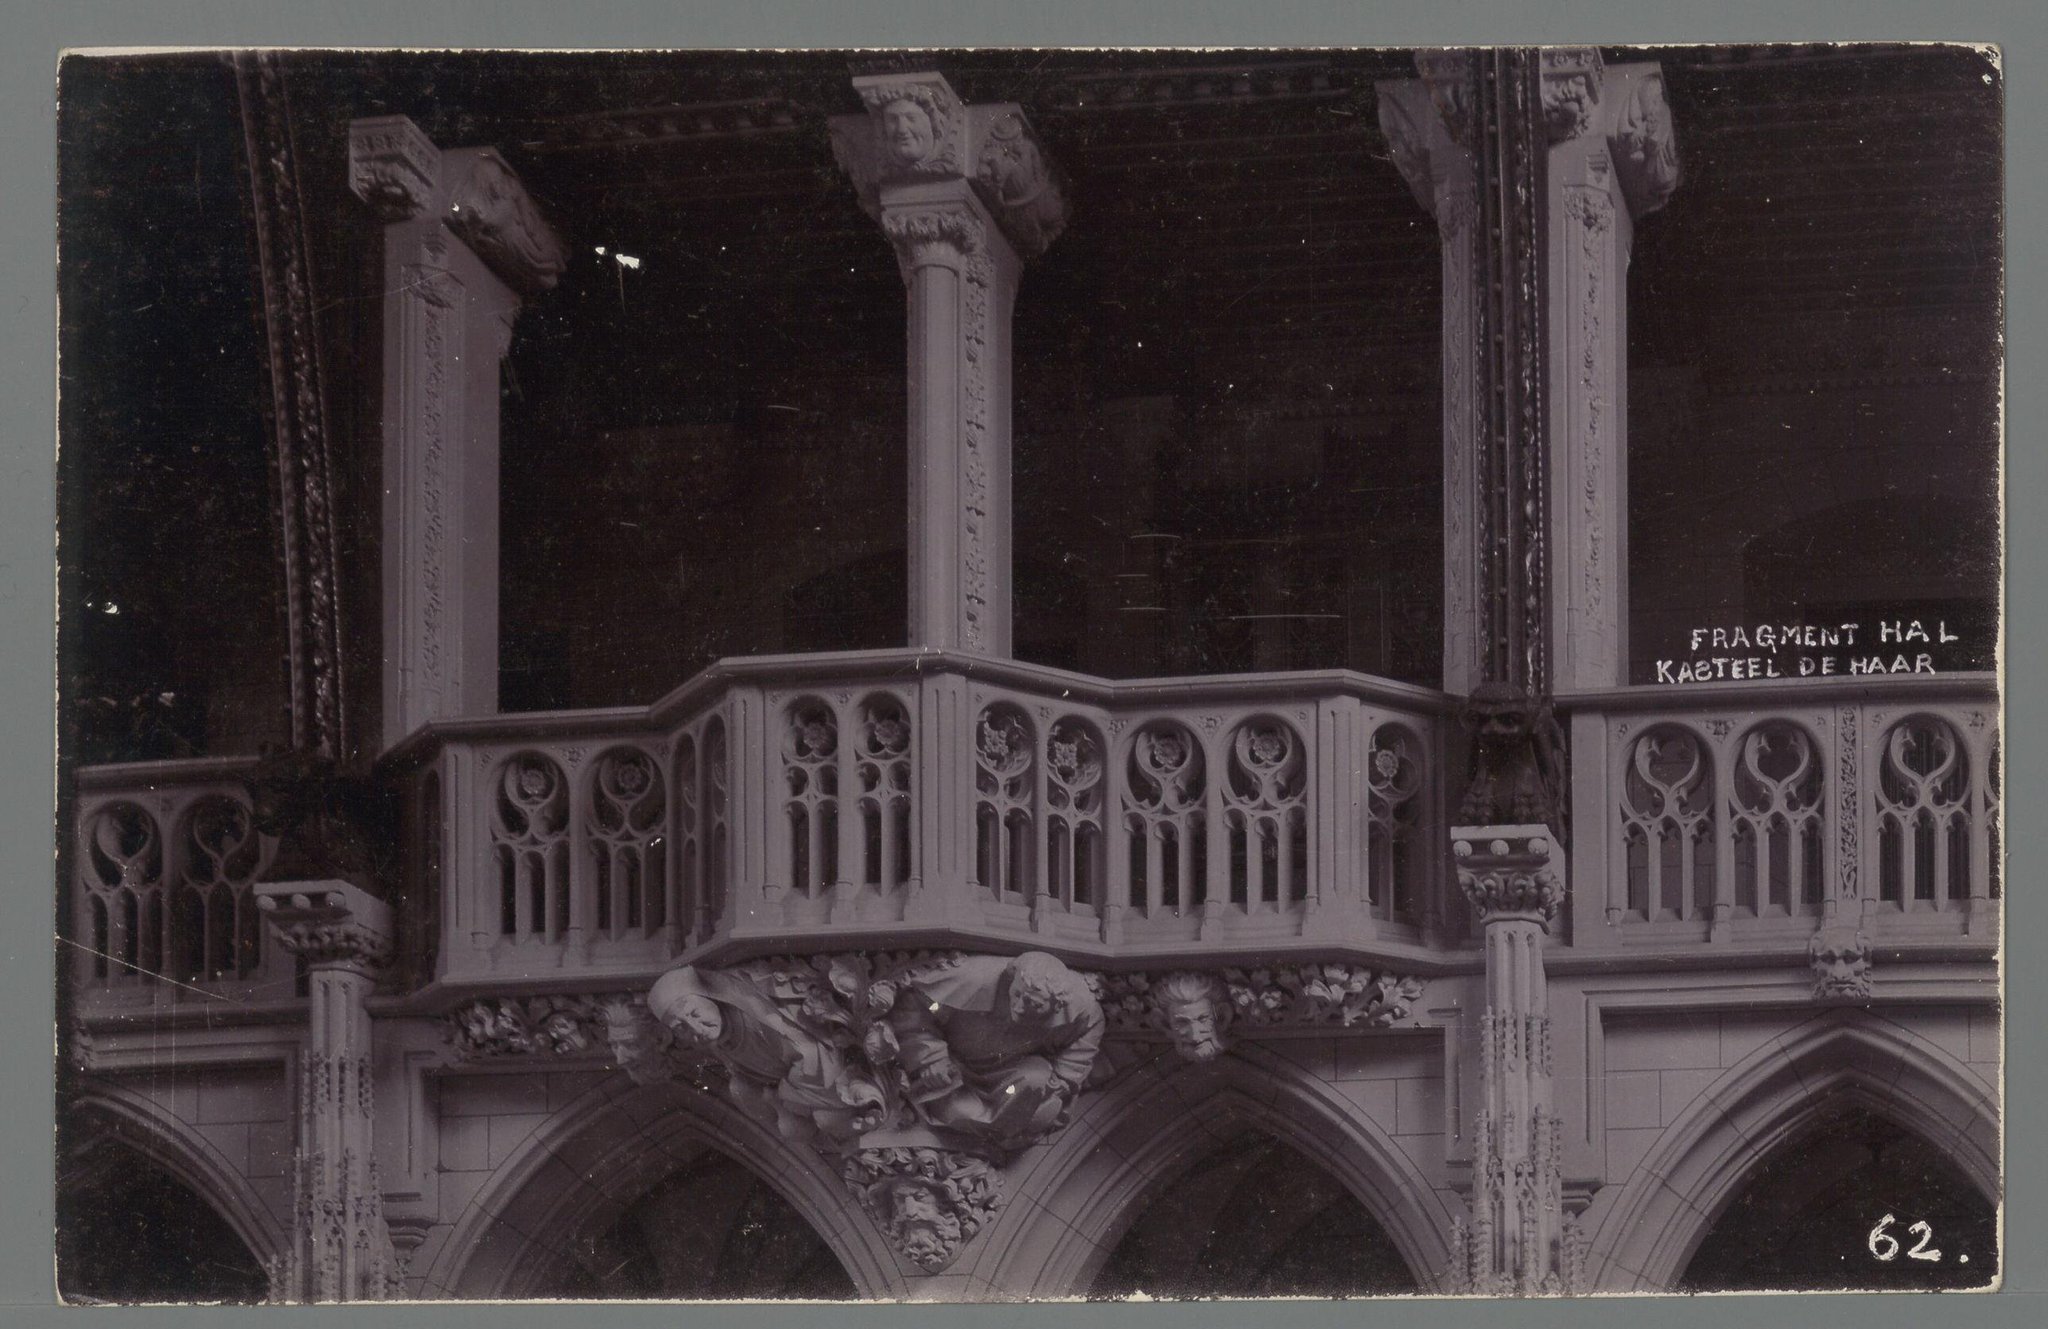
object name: ansichtkaart, prentbriefkaart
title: Fragment hal. Kasteel de Haar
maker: Anonymous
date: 1900-1930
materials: paper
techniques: collodion silver print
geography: haarzuilens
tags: column, pillar ~ architecture, castle, vestibule, hall